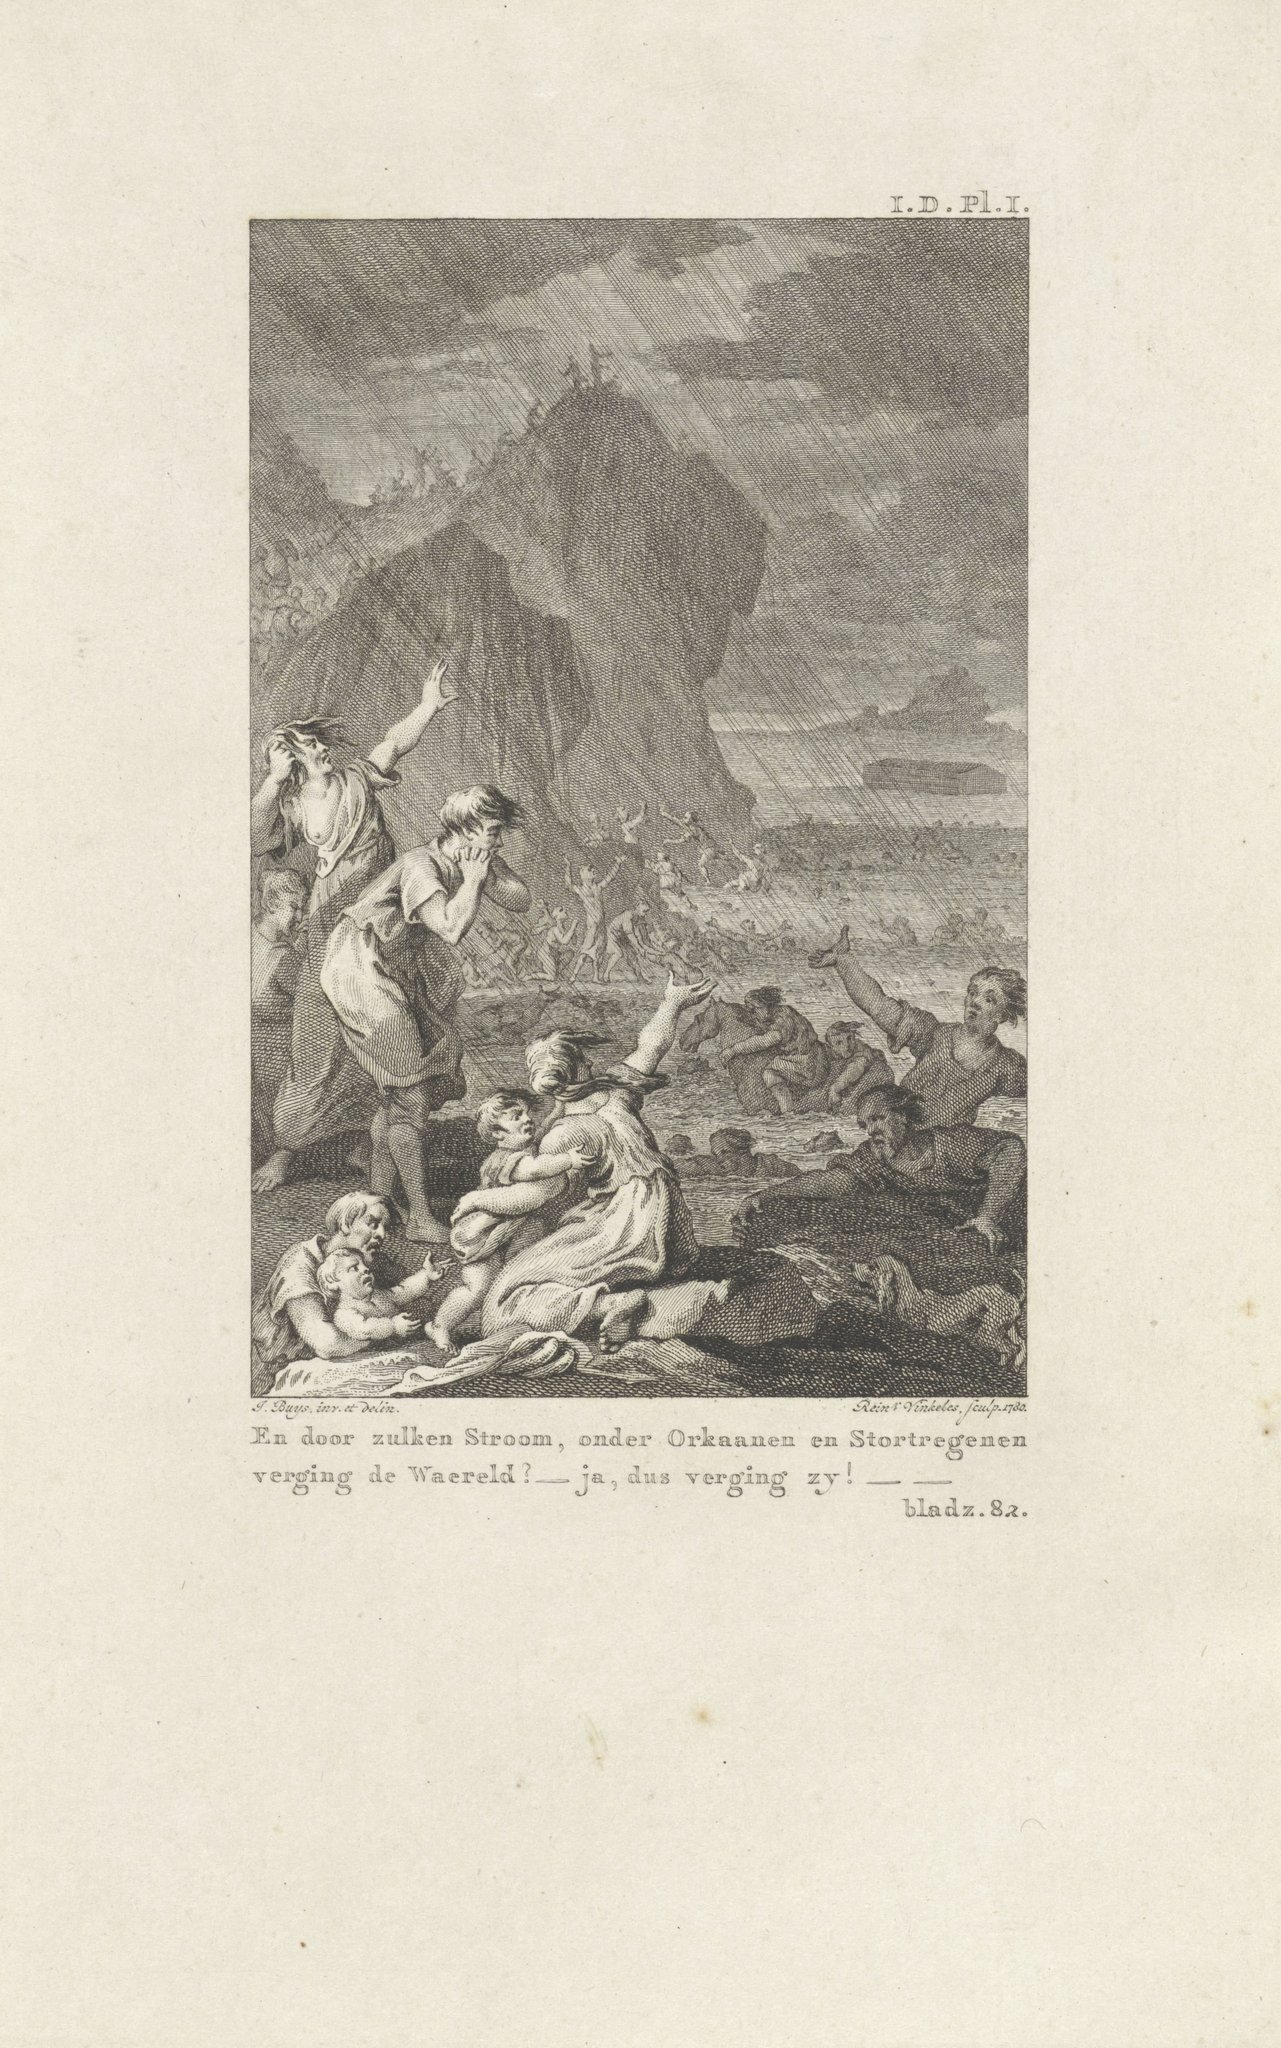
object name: print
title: Zondvloed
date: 1780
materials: paper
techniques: engraving, etching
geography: amsterdam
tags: the flood and destruction of mankind ~ story of noah (genesis 7:10 - 8:17)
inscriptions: collector's mark: Lugt 240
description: Prent gebruikt als boekillustratie in: Martinet, Joannes Florentius. Historie der waereld. Amsterdam: Johannes Allart, 1780-1788. 25 delen. deel I, pl. I.